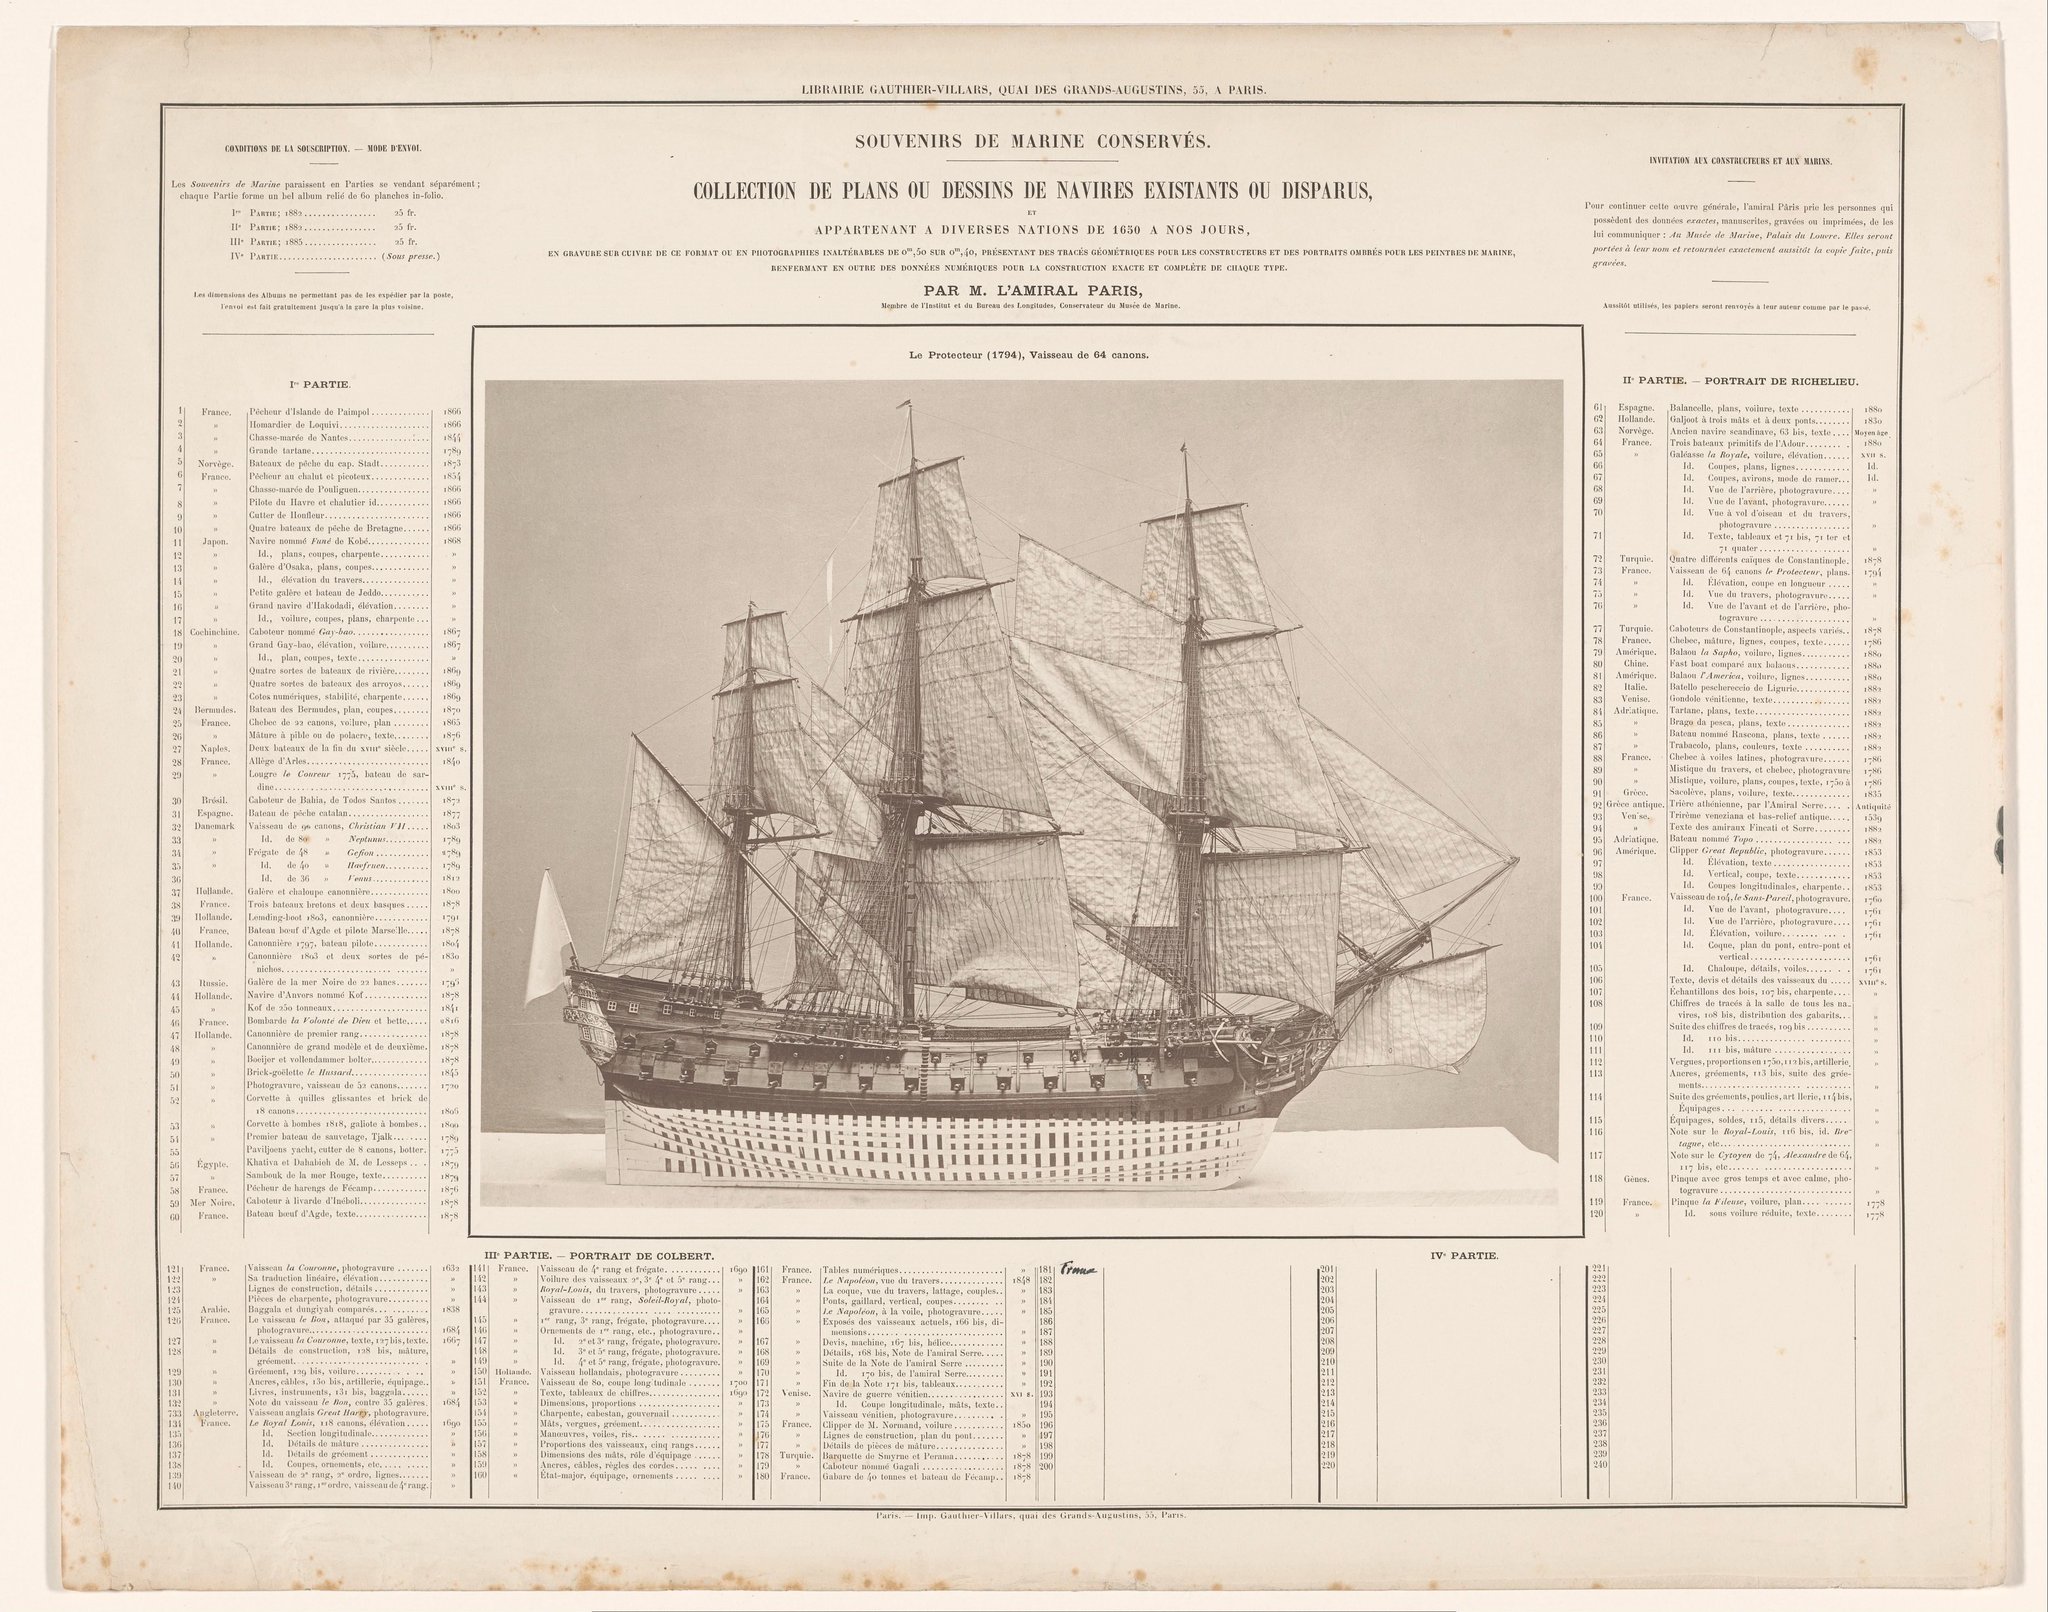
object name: print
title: Inhoudsopgave van Souvenirs de Marine conservés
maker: franҫois-edmond pâris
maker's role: admiraal, museumdirecteur, vice-admiraal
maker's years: 1806-1893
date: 1885-1886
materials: ink, paper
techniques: lithograph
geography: paris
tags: sailing-ship, sailing-boat, ship-model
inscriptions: inscription: ‘France’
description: Prent maakt deel uit van een serie 'Collection de plans ou dessins de navires et de bateaux anciens ou modernes existants ou disparus : avec les éléments numériques nécessaires a leur construction.' uitgegeven tussen 1882-1889 in 4 delen. Deel 5 verscheen in 1892 en deel 6 in 1908. Herdruk verscheen in 1910 en 1972-1976.